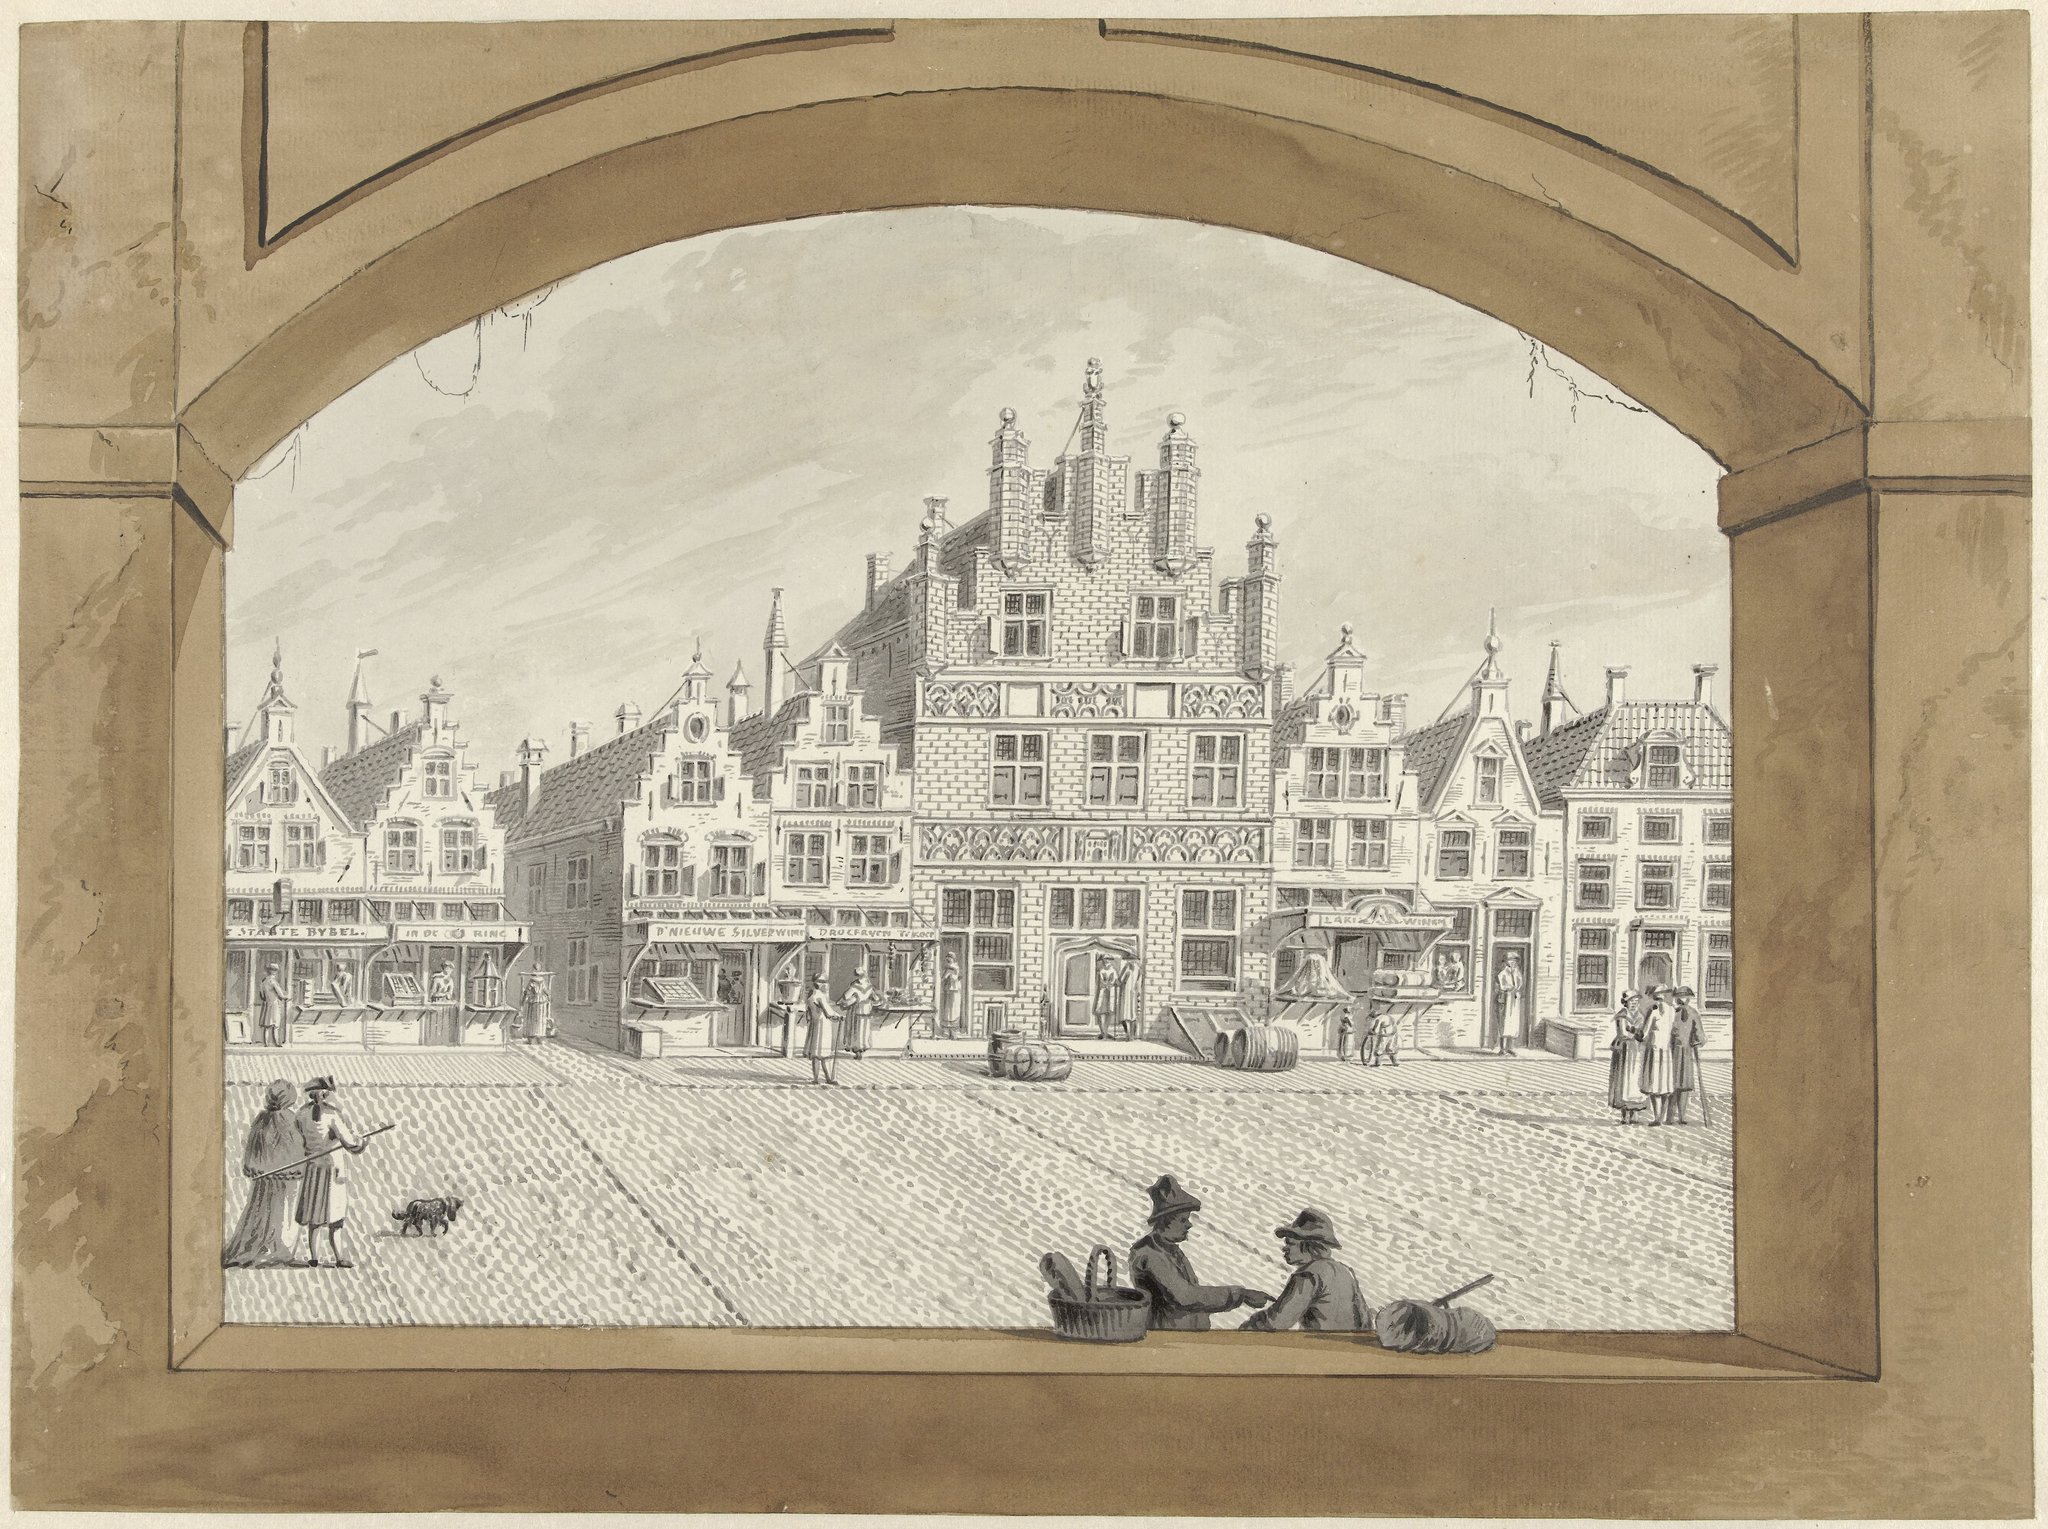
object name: drawing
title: De Koopmanshal in Middelburg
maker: dirk verrijk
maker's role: draughtsman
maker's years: 1734-1786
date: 1744-1786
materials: ink, paper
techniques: brush, pen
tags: street, middelburg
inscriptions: inscription